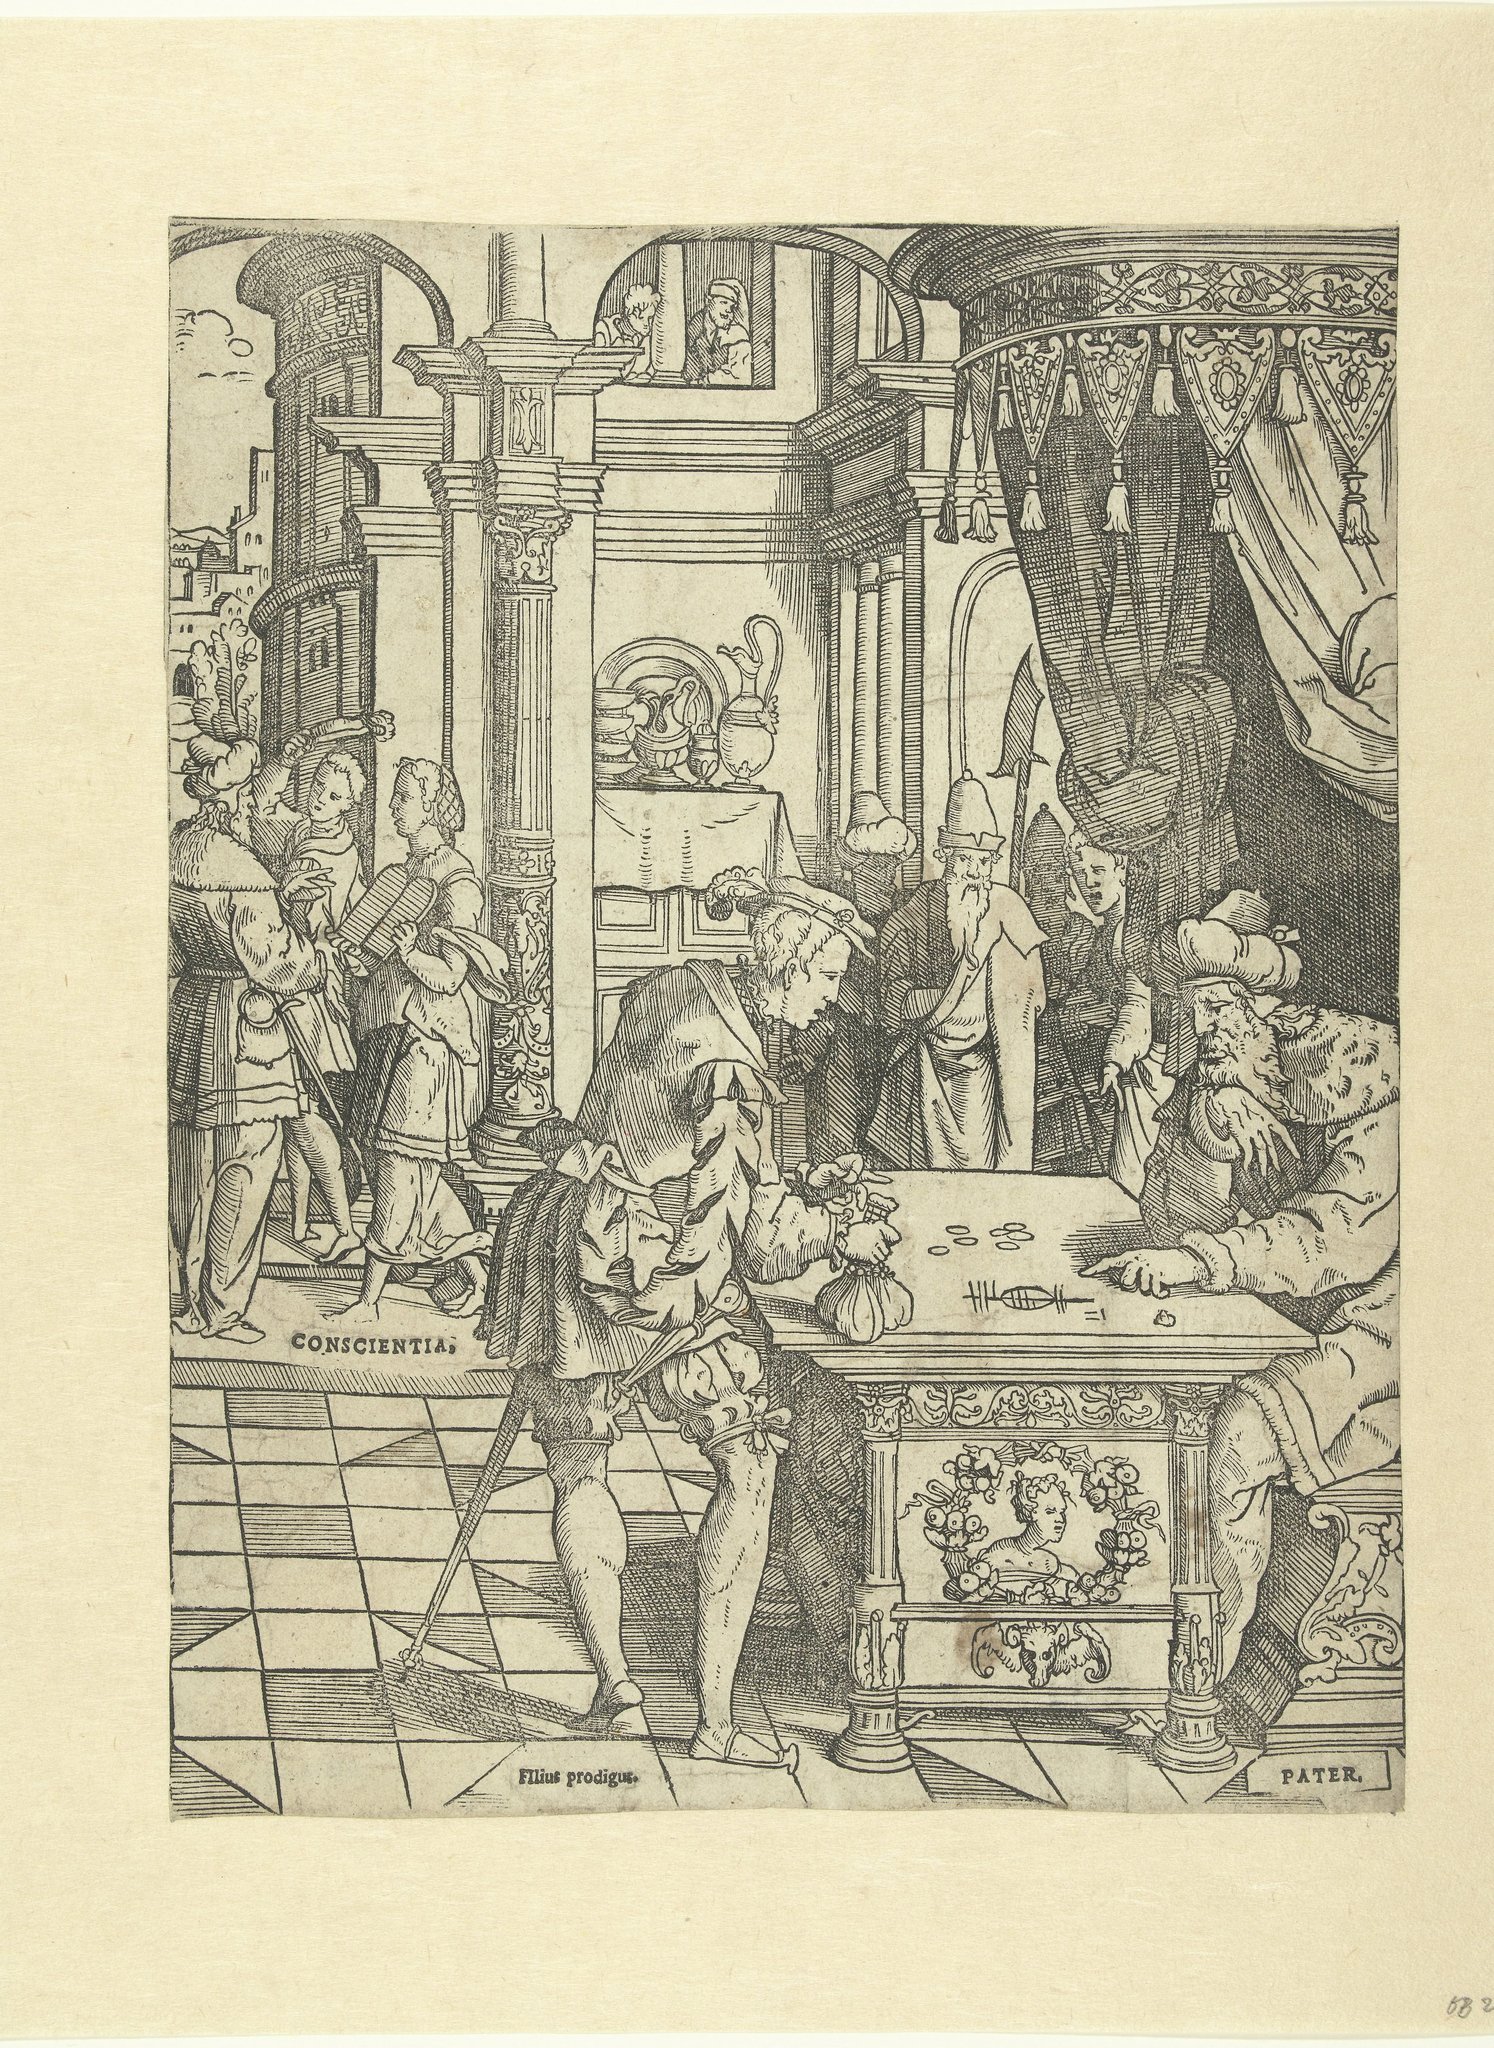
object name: print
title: Allegorie van de verloren zoon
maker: cornelis anthonisz.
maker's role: draughtsman, painter, print maker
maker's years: 1499-1553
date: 1535-1545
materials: paper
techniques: woodcut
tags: the prodigal son asks for his inheritance; his father gives him (a bag of) money, conscience; 'coscienza' (ripa), leave-taking and departure of the prodigal son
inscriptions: collector's mark: Lugt 2228a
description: Eén van serie van zes. Vader (pater) gezeten aan tafel onder baldakijn, zoon (filius prodigus) tegenover hem met geldbuidel. Op achtergrond vertrek van zoon, begeleid door het Geweten (conscientia).